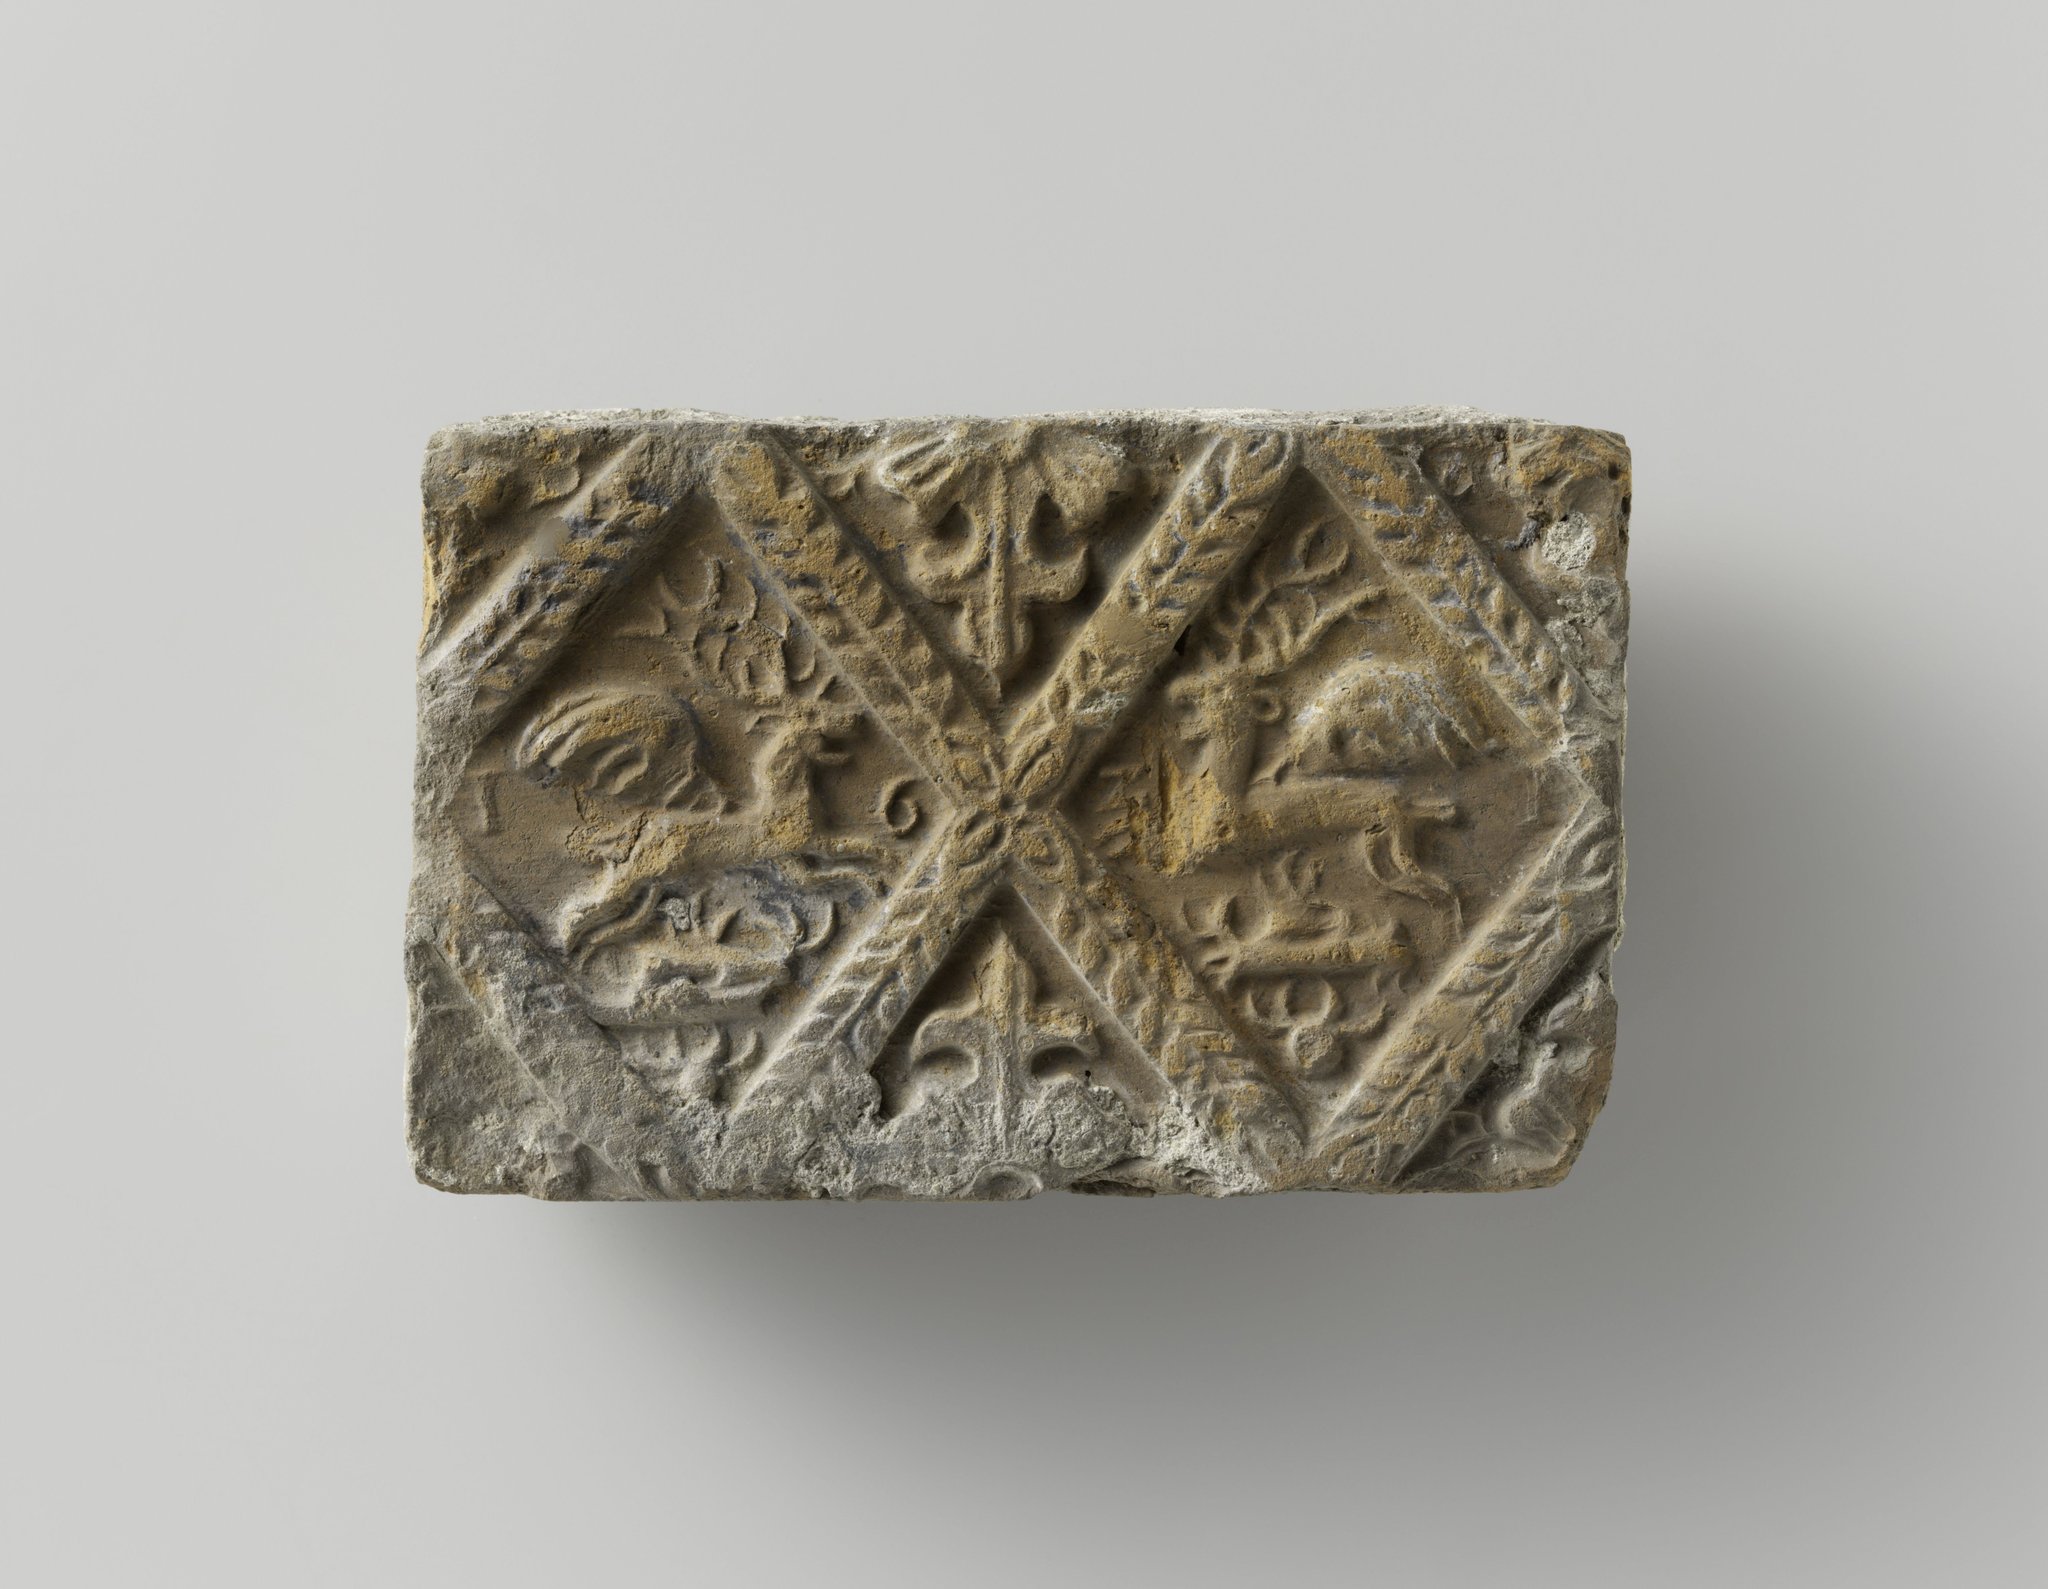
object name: hearthstone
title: Haardsteen met voorstelling van twee gevleugelde herten, geplaatst in twee ruiten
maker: Anonymous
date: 1606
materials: earthenware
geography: southern netherlands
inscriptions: date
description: Haardsteen met voorstelling van twee gevleugelde herten, geplaatst in twee ruiten. Met het jaartal 1606.